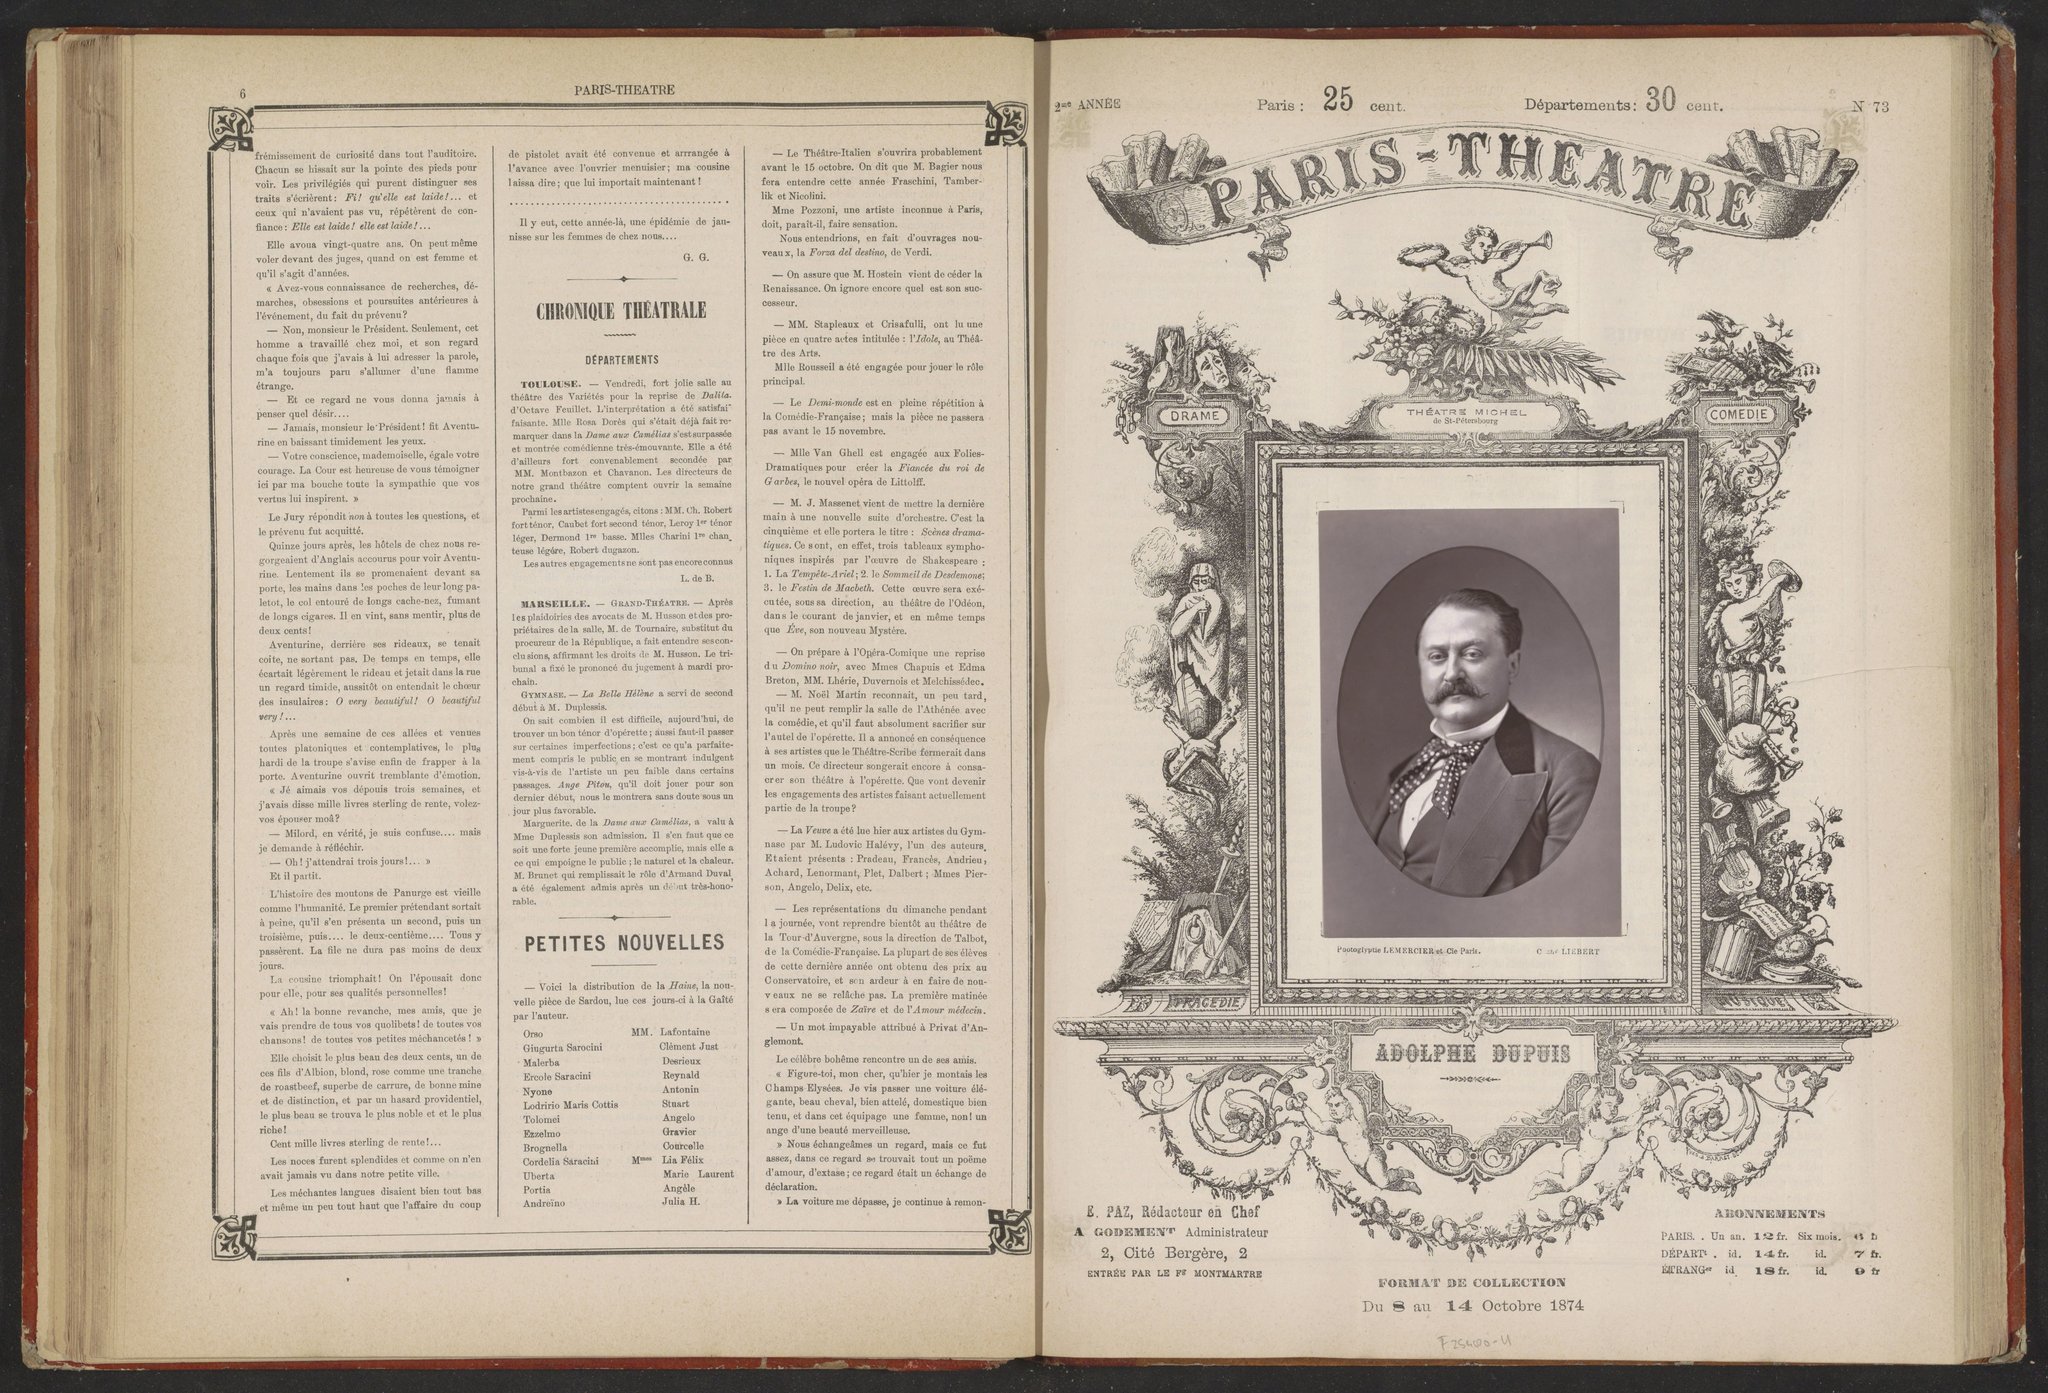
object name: photomechanical print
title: Portret van Adolphe Dupuis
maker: alphonse-justin liébert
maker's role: fotograaf, marinier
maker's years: 1827-1914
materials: paper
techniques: woodburytype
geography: france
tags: portrait of actor, actress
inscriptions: inscription: ‘Du 8 au 14 Octobre 1874’, number: ‘No 73’